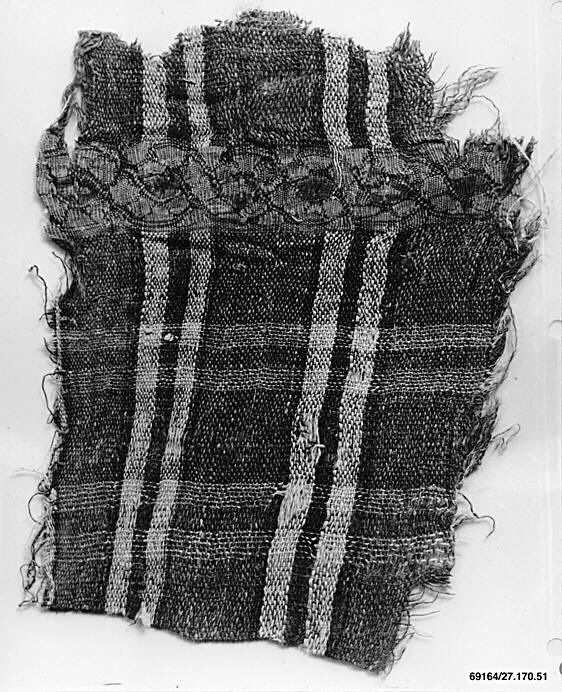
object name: textile fragment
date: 1101-1200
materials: linen, silk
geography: egypt